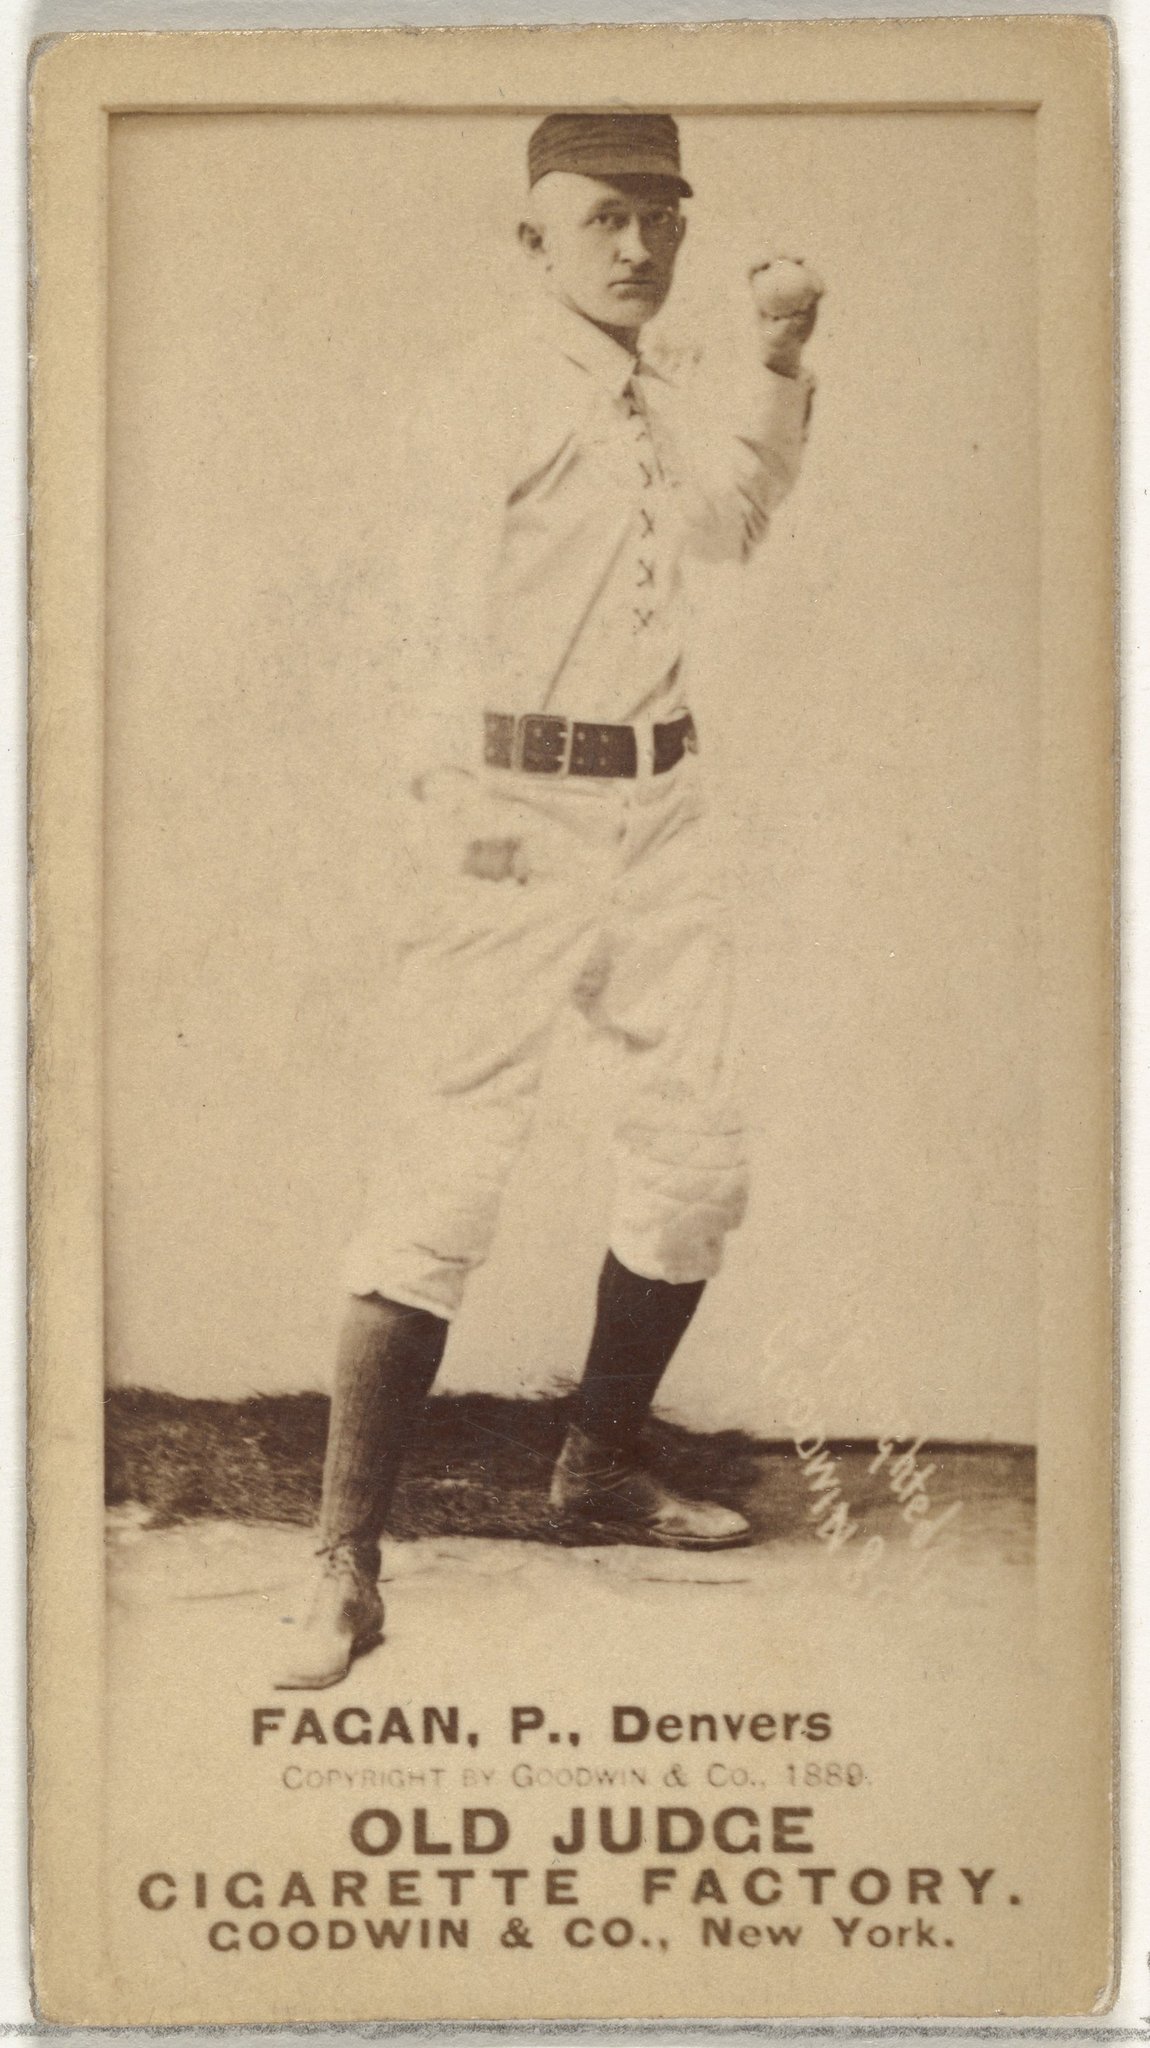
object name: baseball card, photograph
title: William A. "Bill" Fagan, Pitcher, Denver, from the Old Judge series (N172) for Old Judge Cigarettes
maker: goodwin & company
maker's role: publisher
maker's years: 1850-1950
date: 1889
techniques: albumen silver print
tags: men,portraits,baseball,athletes